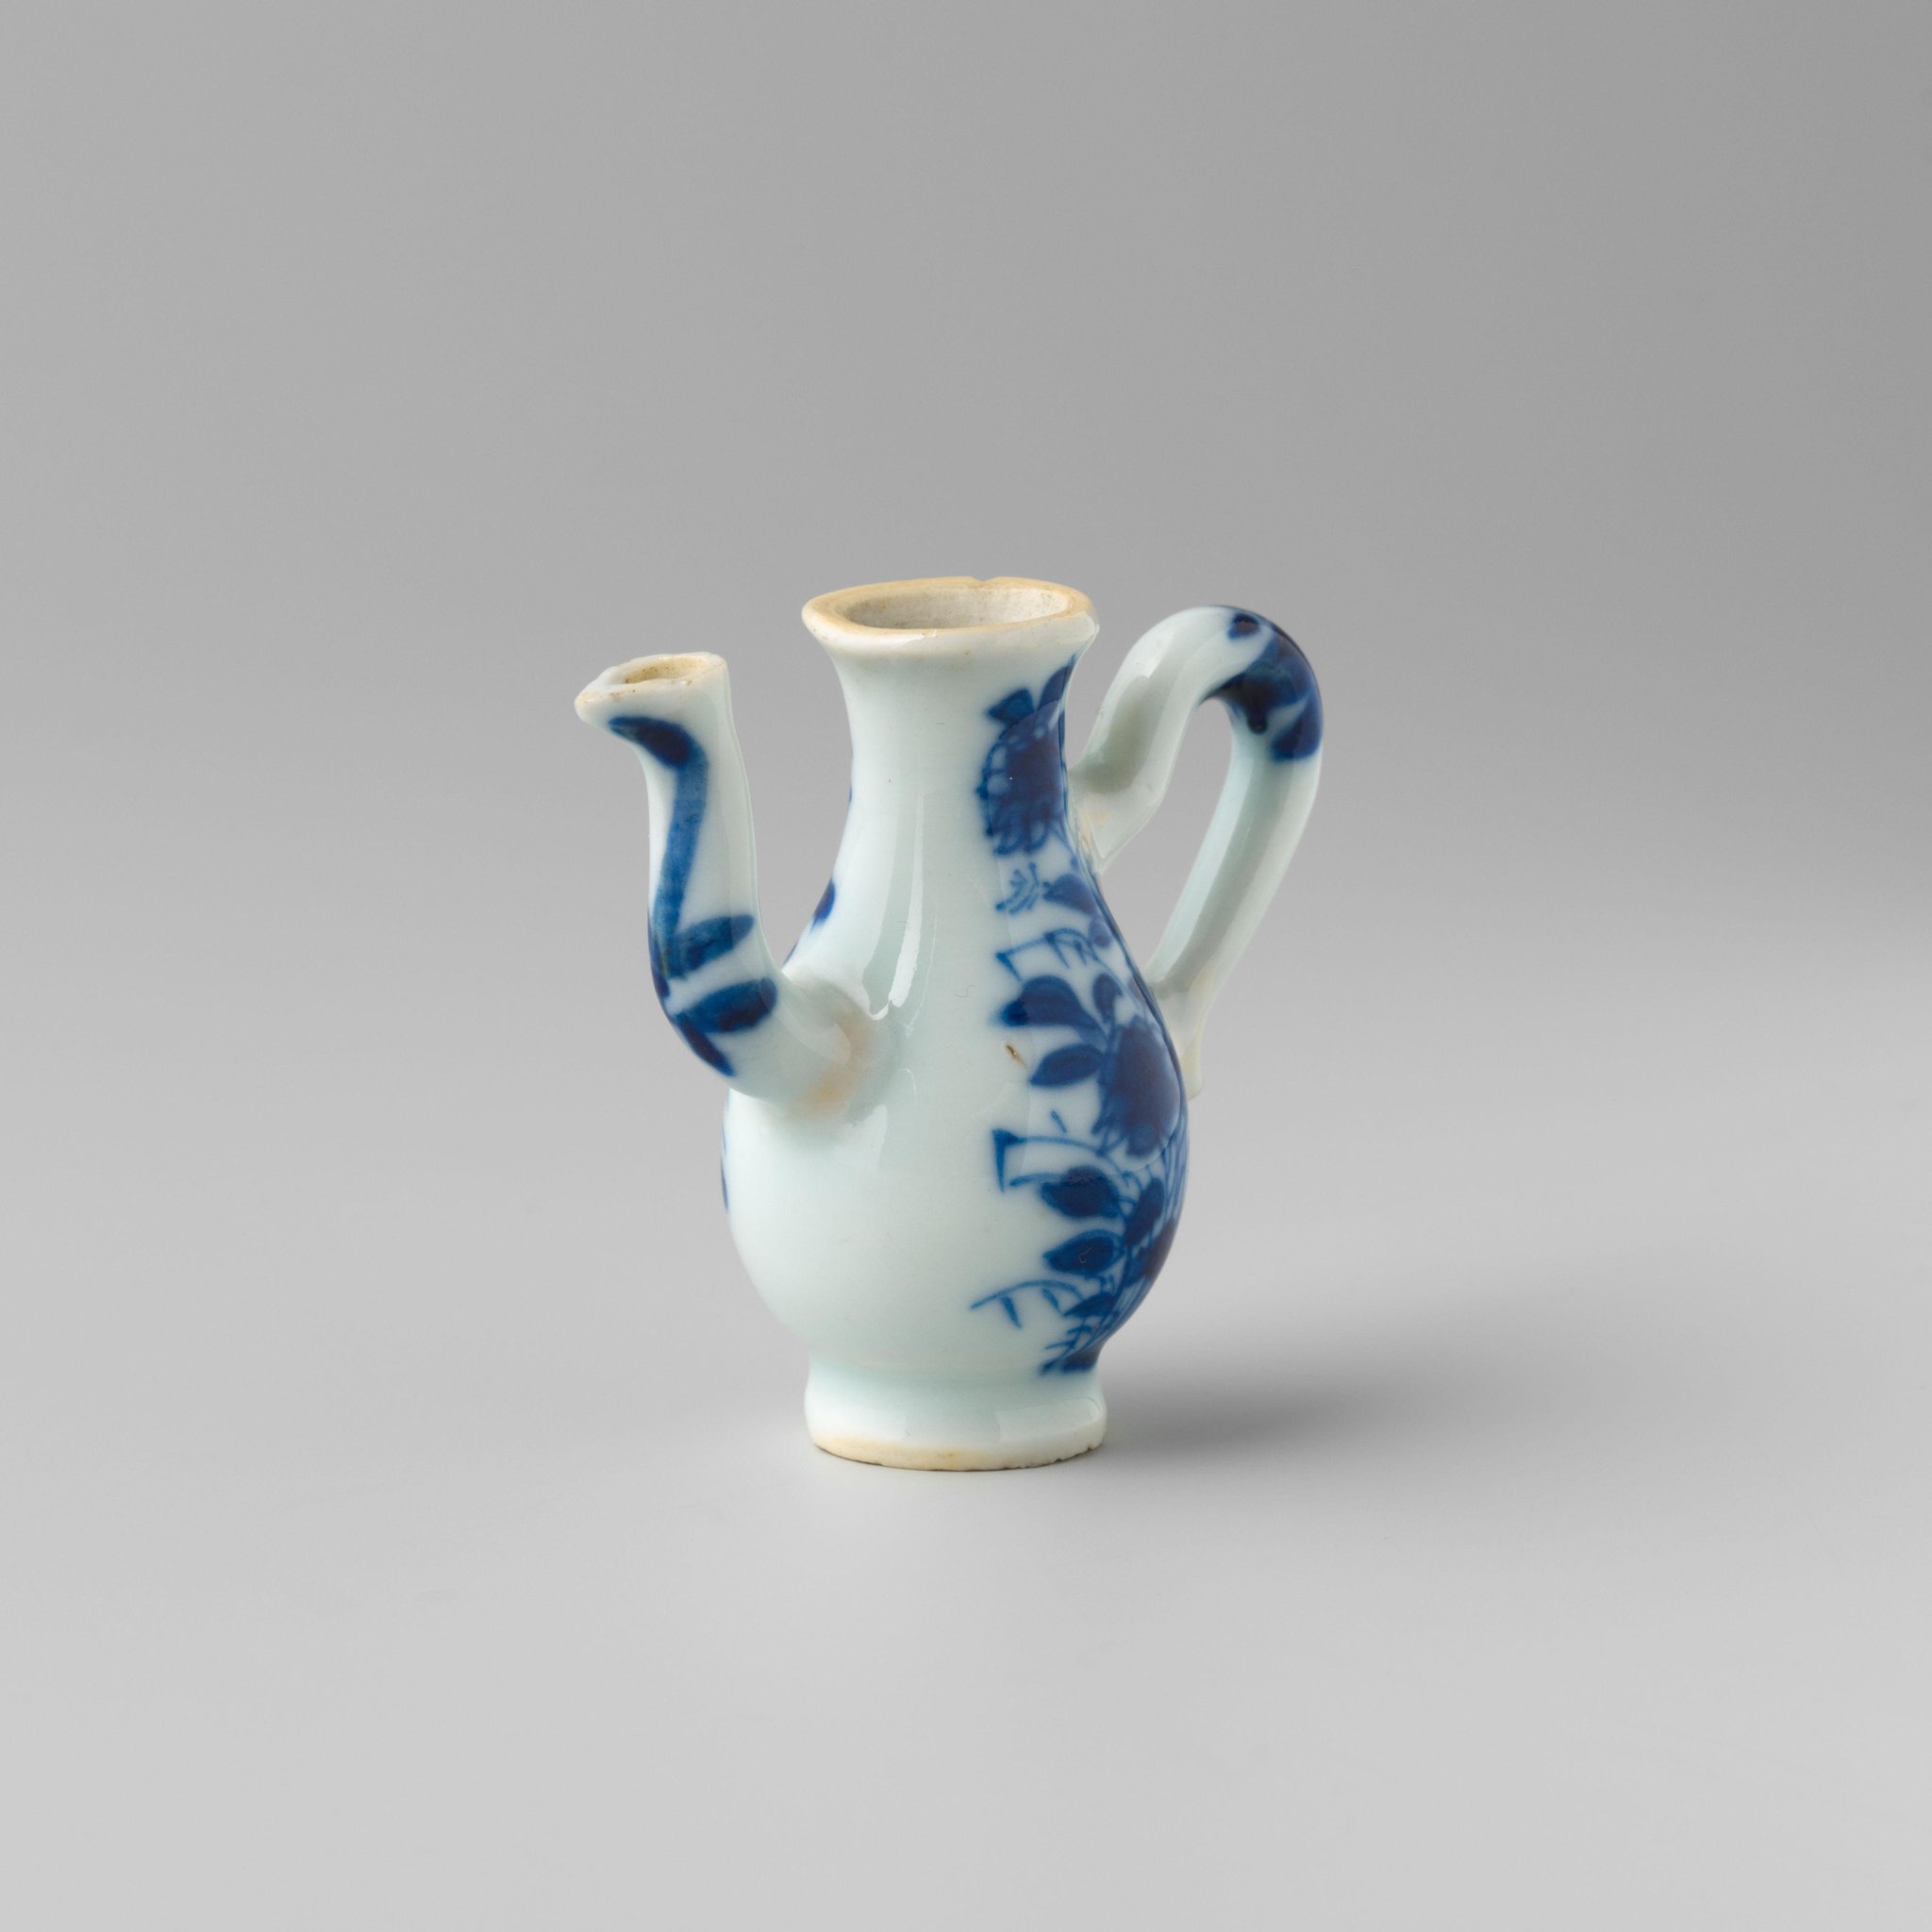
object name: ewer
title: Miniature ovoid ewer with flowering plants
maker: Anonymous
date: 1675-1724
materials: cobalt, glaze, paint, porcelain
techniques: firing, turning, vitrification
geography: china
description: Miniatuur eivormige kan van porselein met een gebogen tuit en S-vormig oor, beschilderd in onderglazuur blauw. Op de kan bloeiende planten. Blauw-wit.